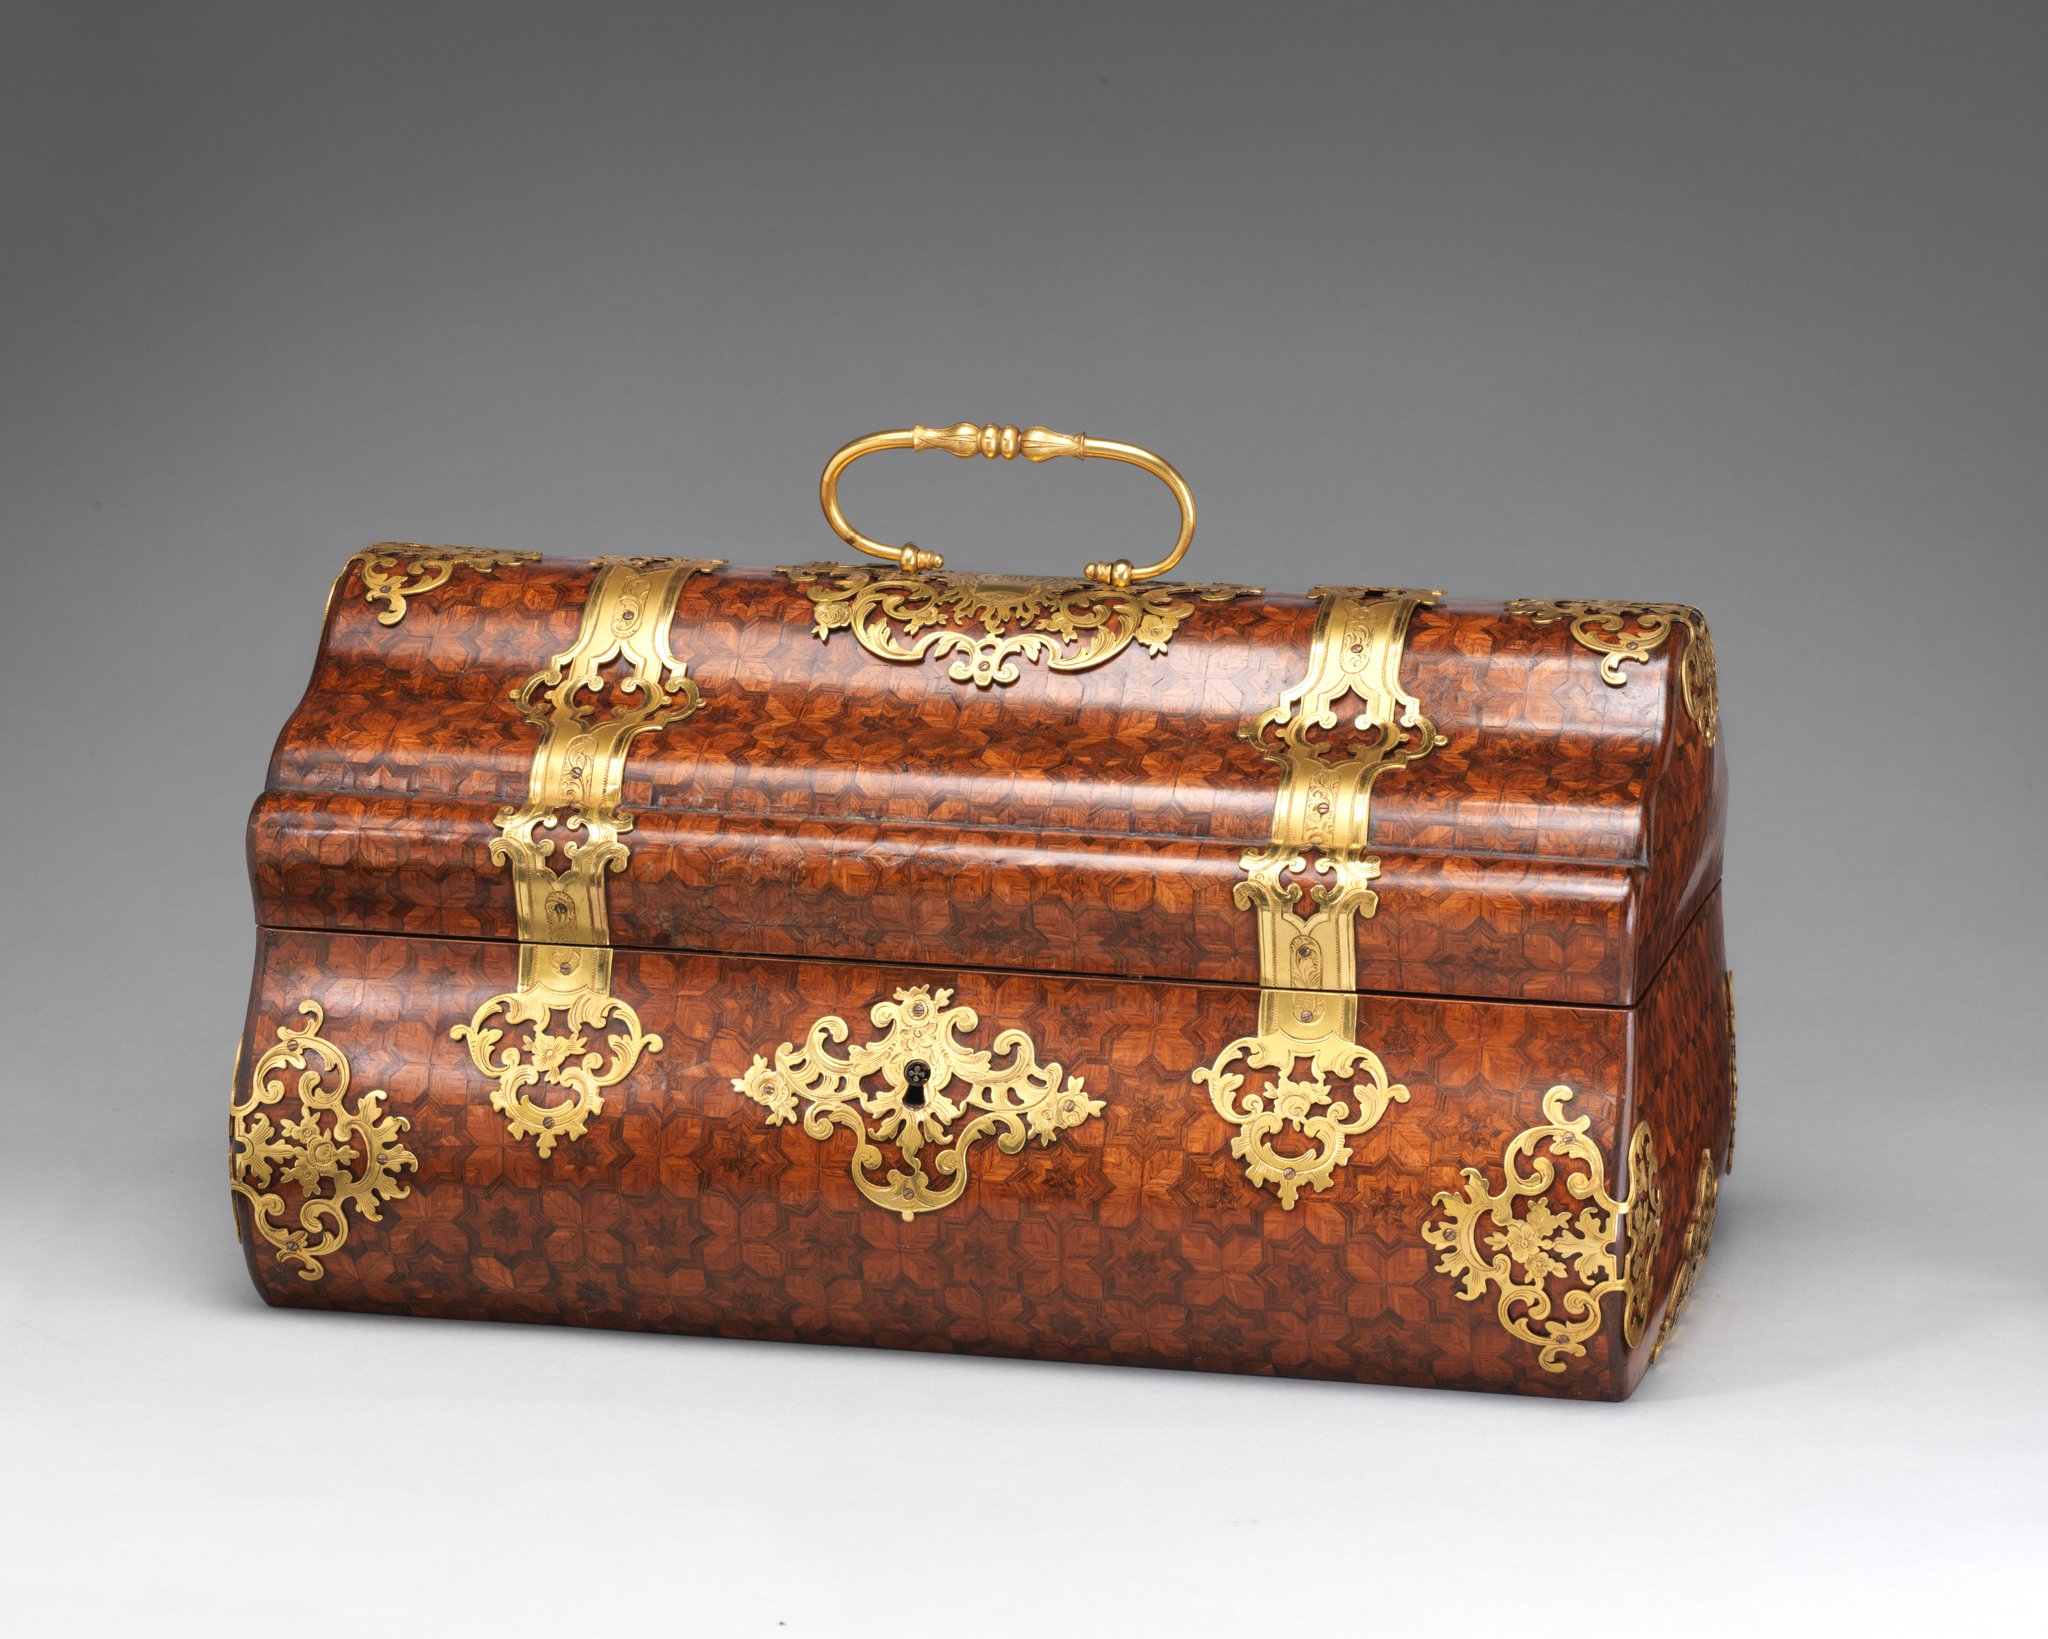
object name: box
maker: alphonse giroux & cie., paris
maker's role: maker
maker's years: 1775-1848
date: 1860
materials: gilt bronze, metal thread, silk, wood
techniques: lining, veneering